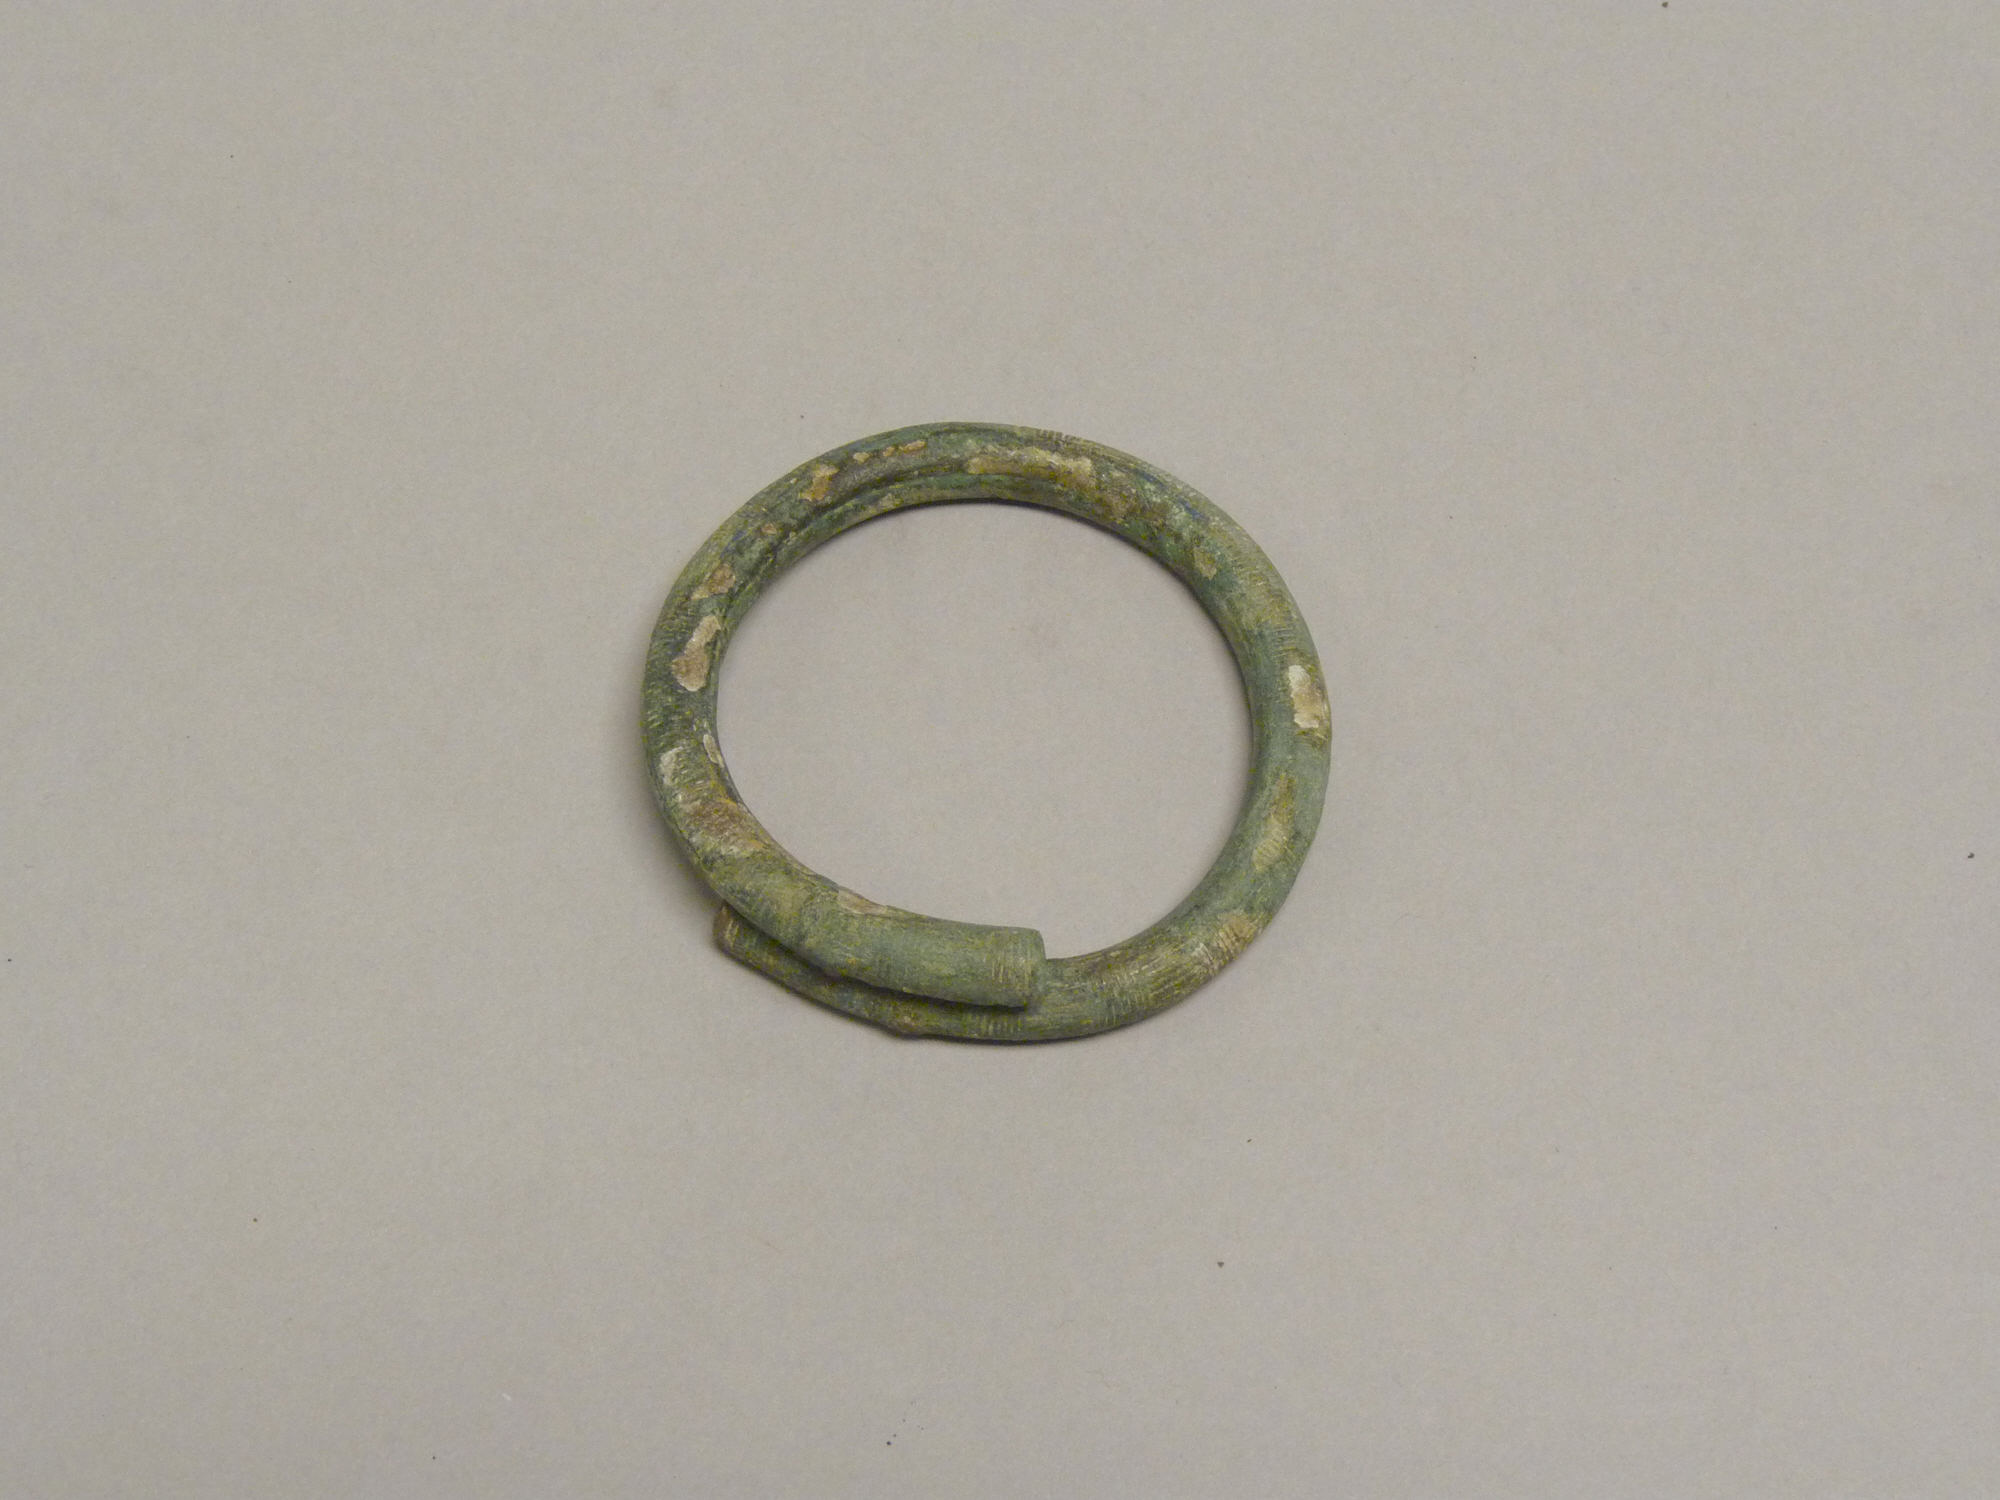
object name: bangle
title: Solid Open Bangle with Subtle Basketweave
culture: thai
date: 1000 BCE-400 CE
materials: bronze